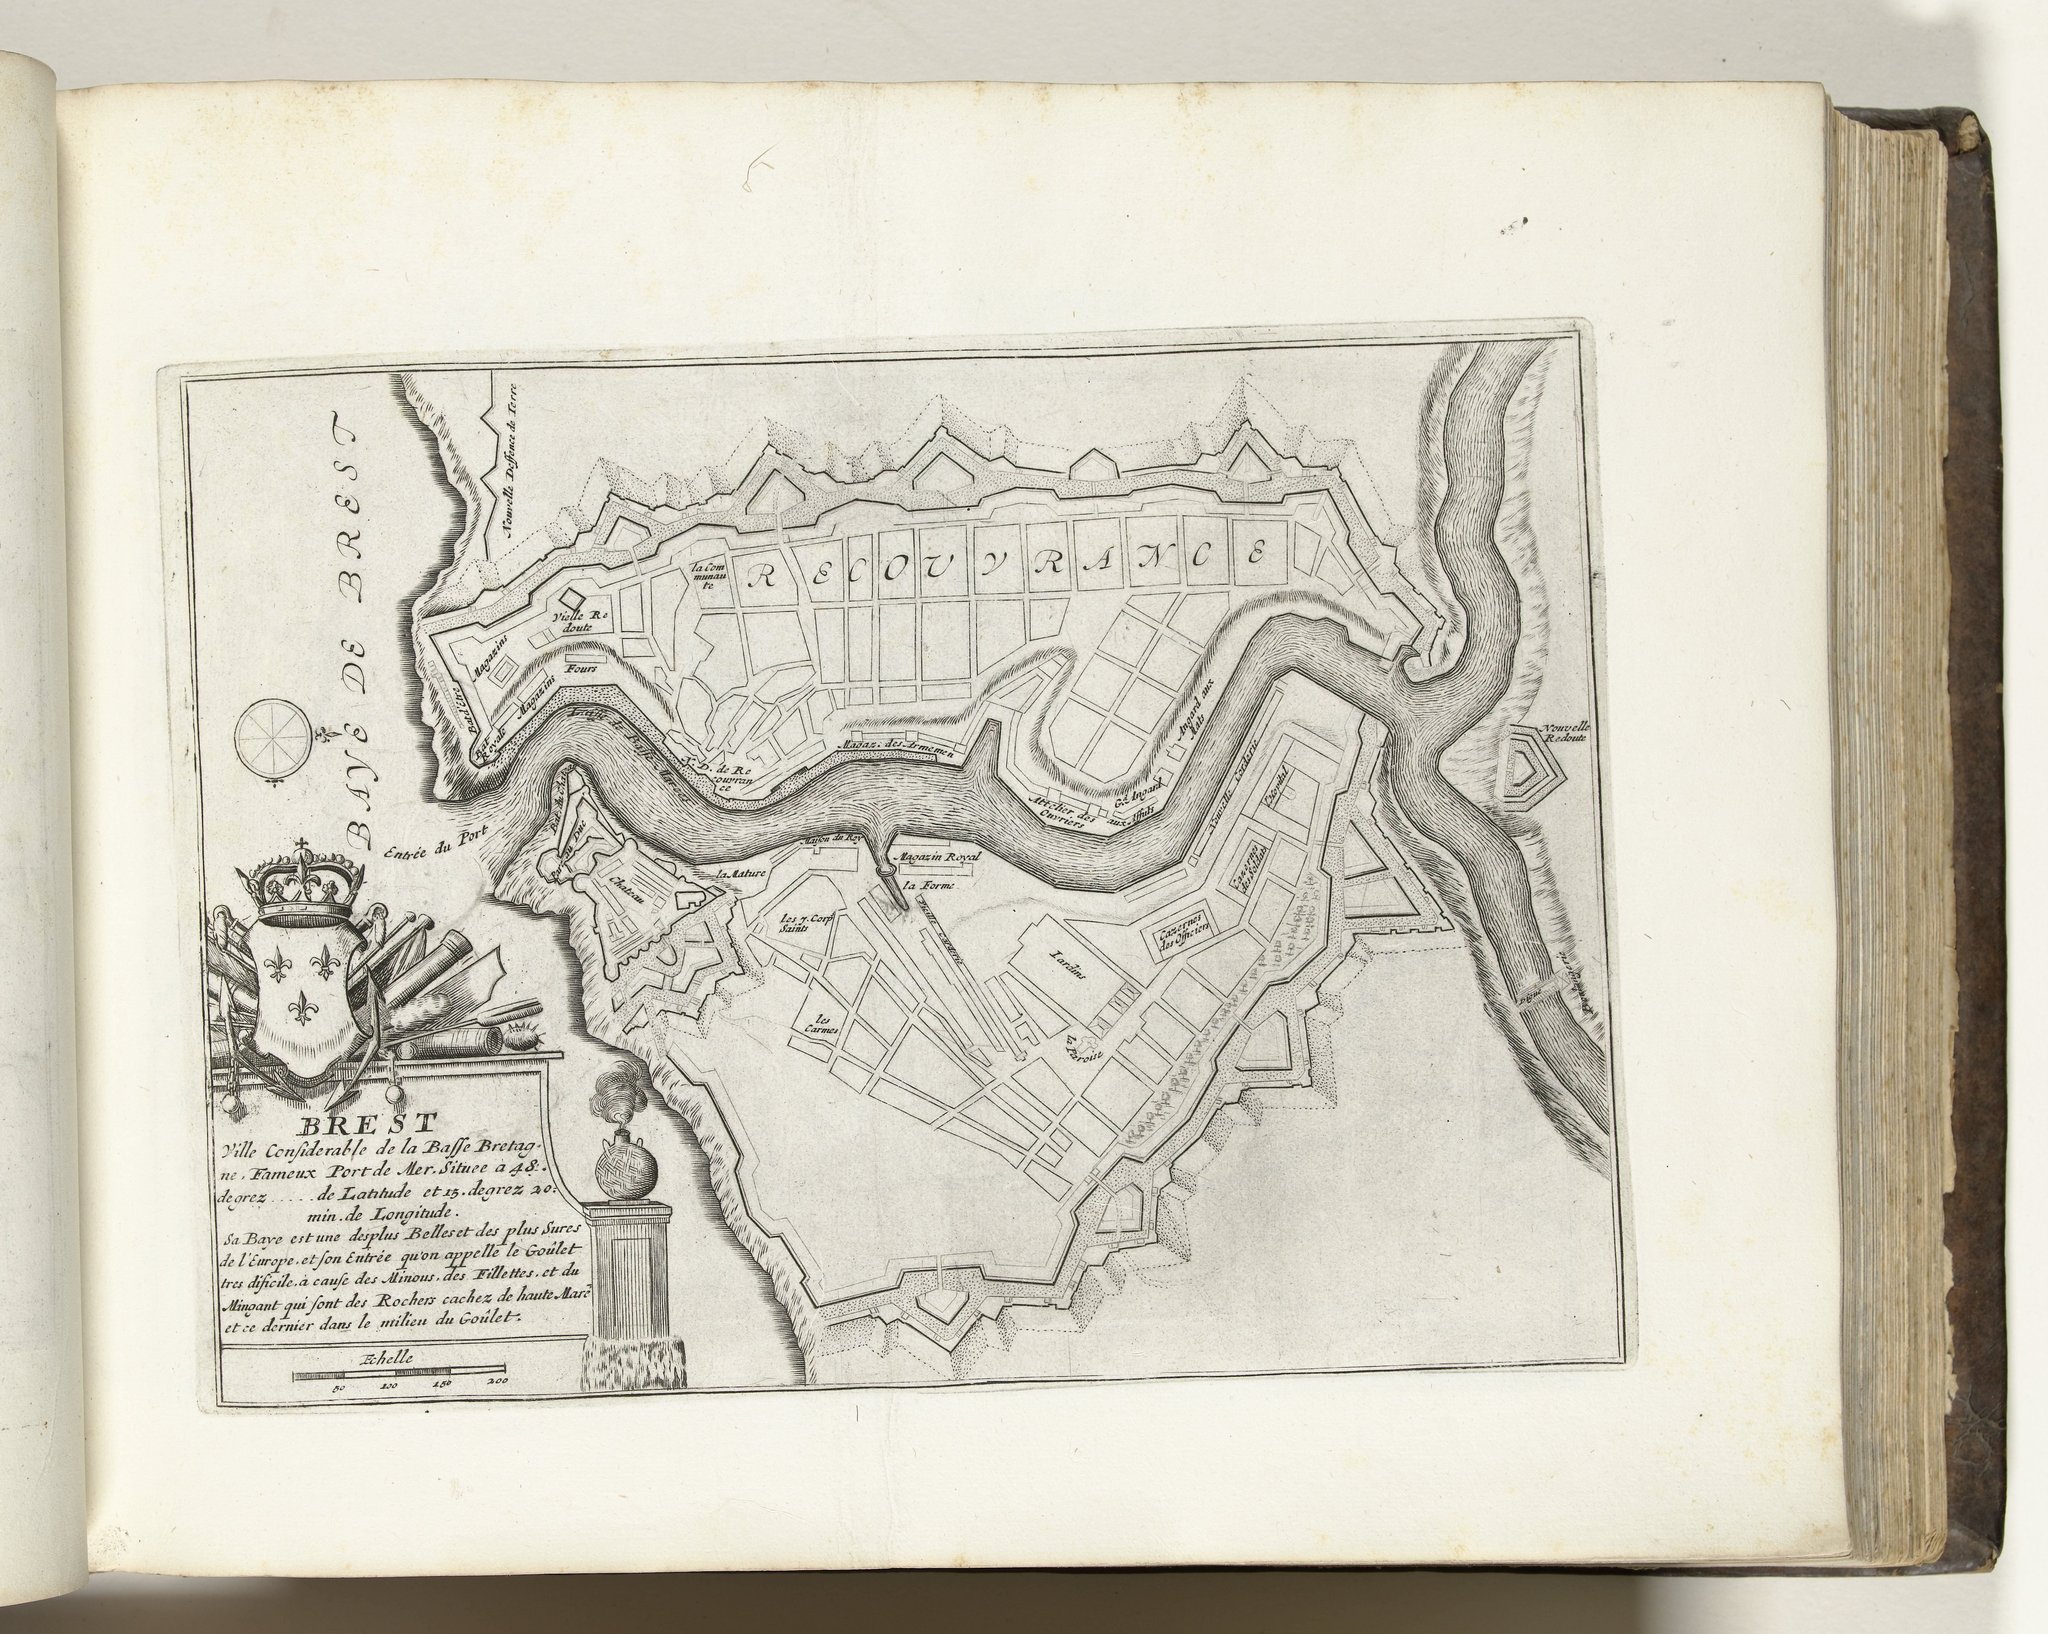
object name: map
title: Plattegrond van Brest, ca. 1693-1695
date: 1693-1695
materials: paper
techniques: engraving, etching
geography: paris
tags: fortress, maps of cities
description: Plattegrond van de versterkingen om de Franse stad Brest. Onderdeel van het derde deel (1695) van het prentwerk waarin gebundeld zijn de acht delen van Les forces de l'Europe uitgegeven tussen 1693-1697. Het prentwerk bestaat uit 175 platen met plannen (afkomstig van Sébastien Le Prestre, Seigneur de Vauban) van vermaarde sterke steden en vestingen in de Negenjarige Oorlog. Titel en opschriften in het Frans.